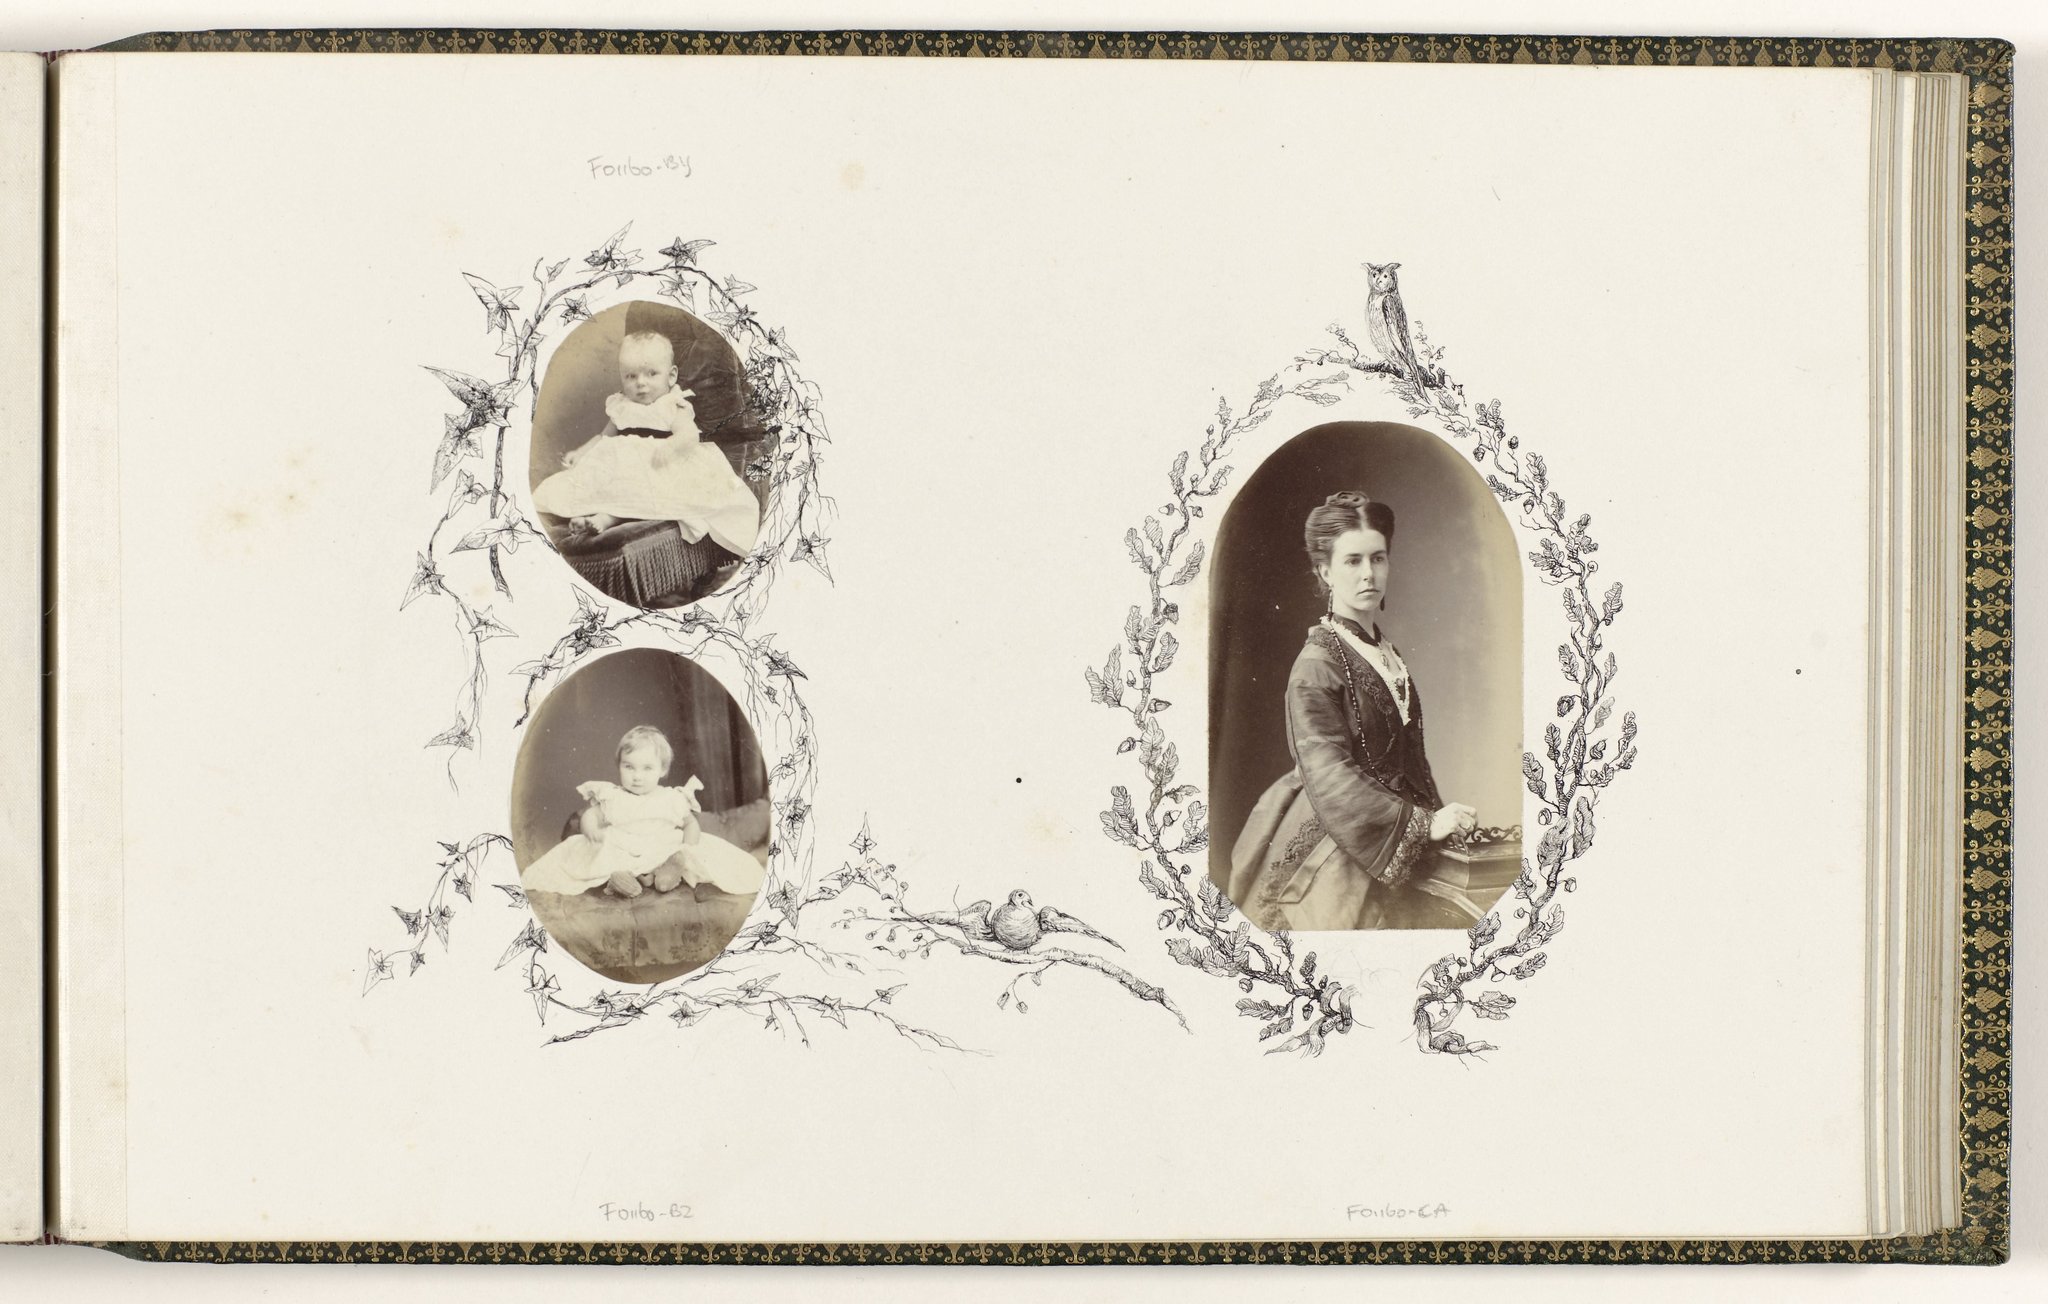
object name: album leaf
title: Portret van een onbekend kind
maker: Anonymous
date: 1870-1880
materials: paper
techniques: albumen print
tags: historical persons, infant, baby